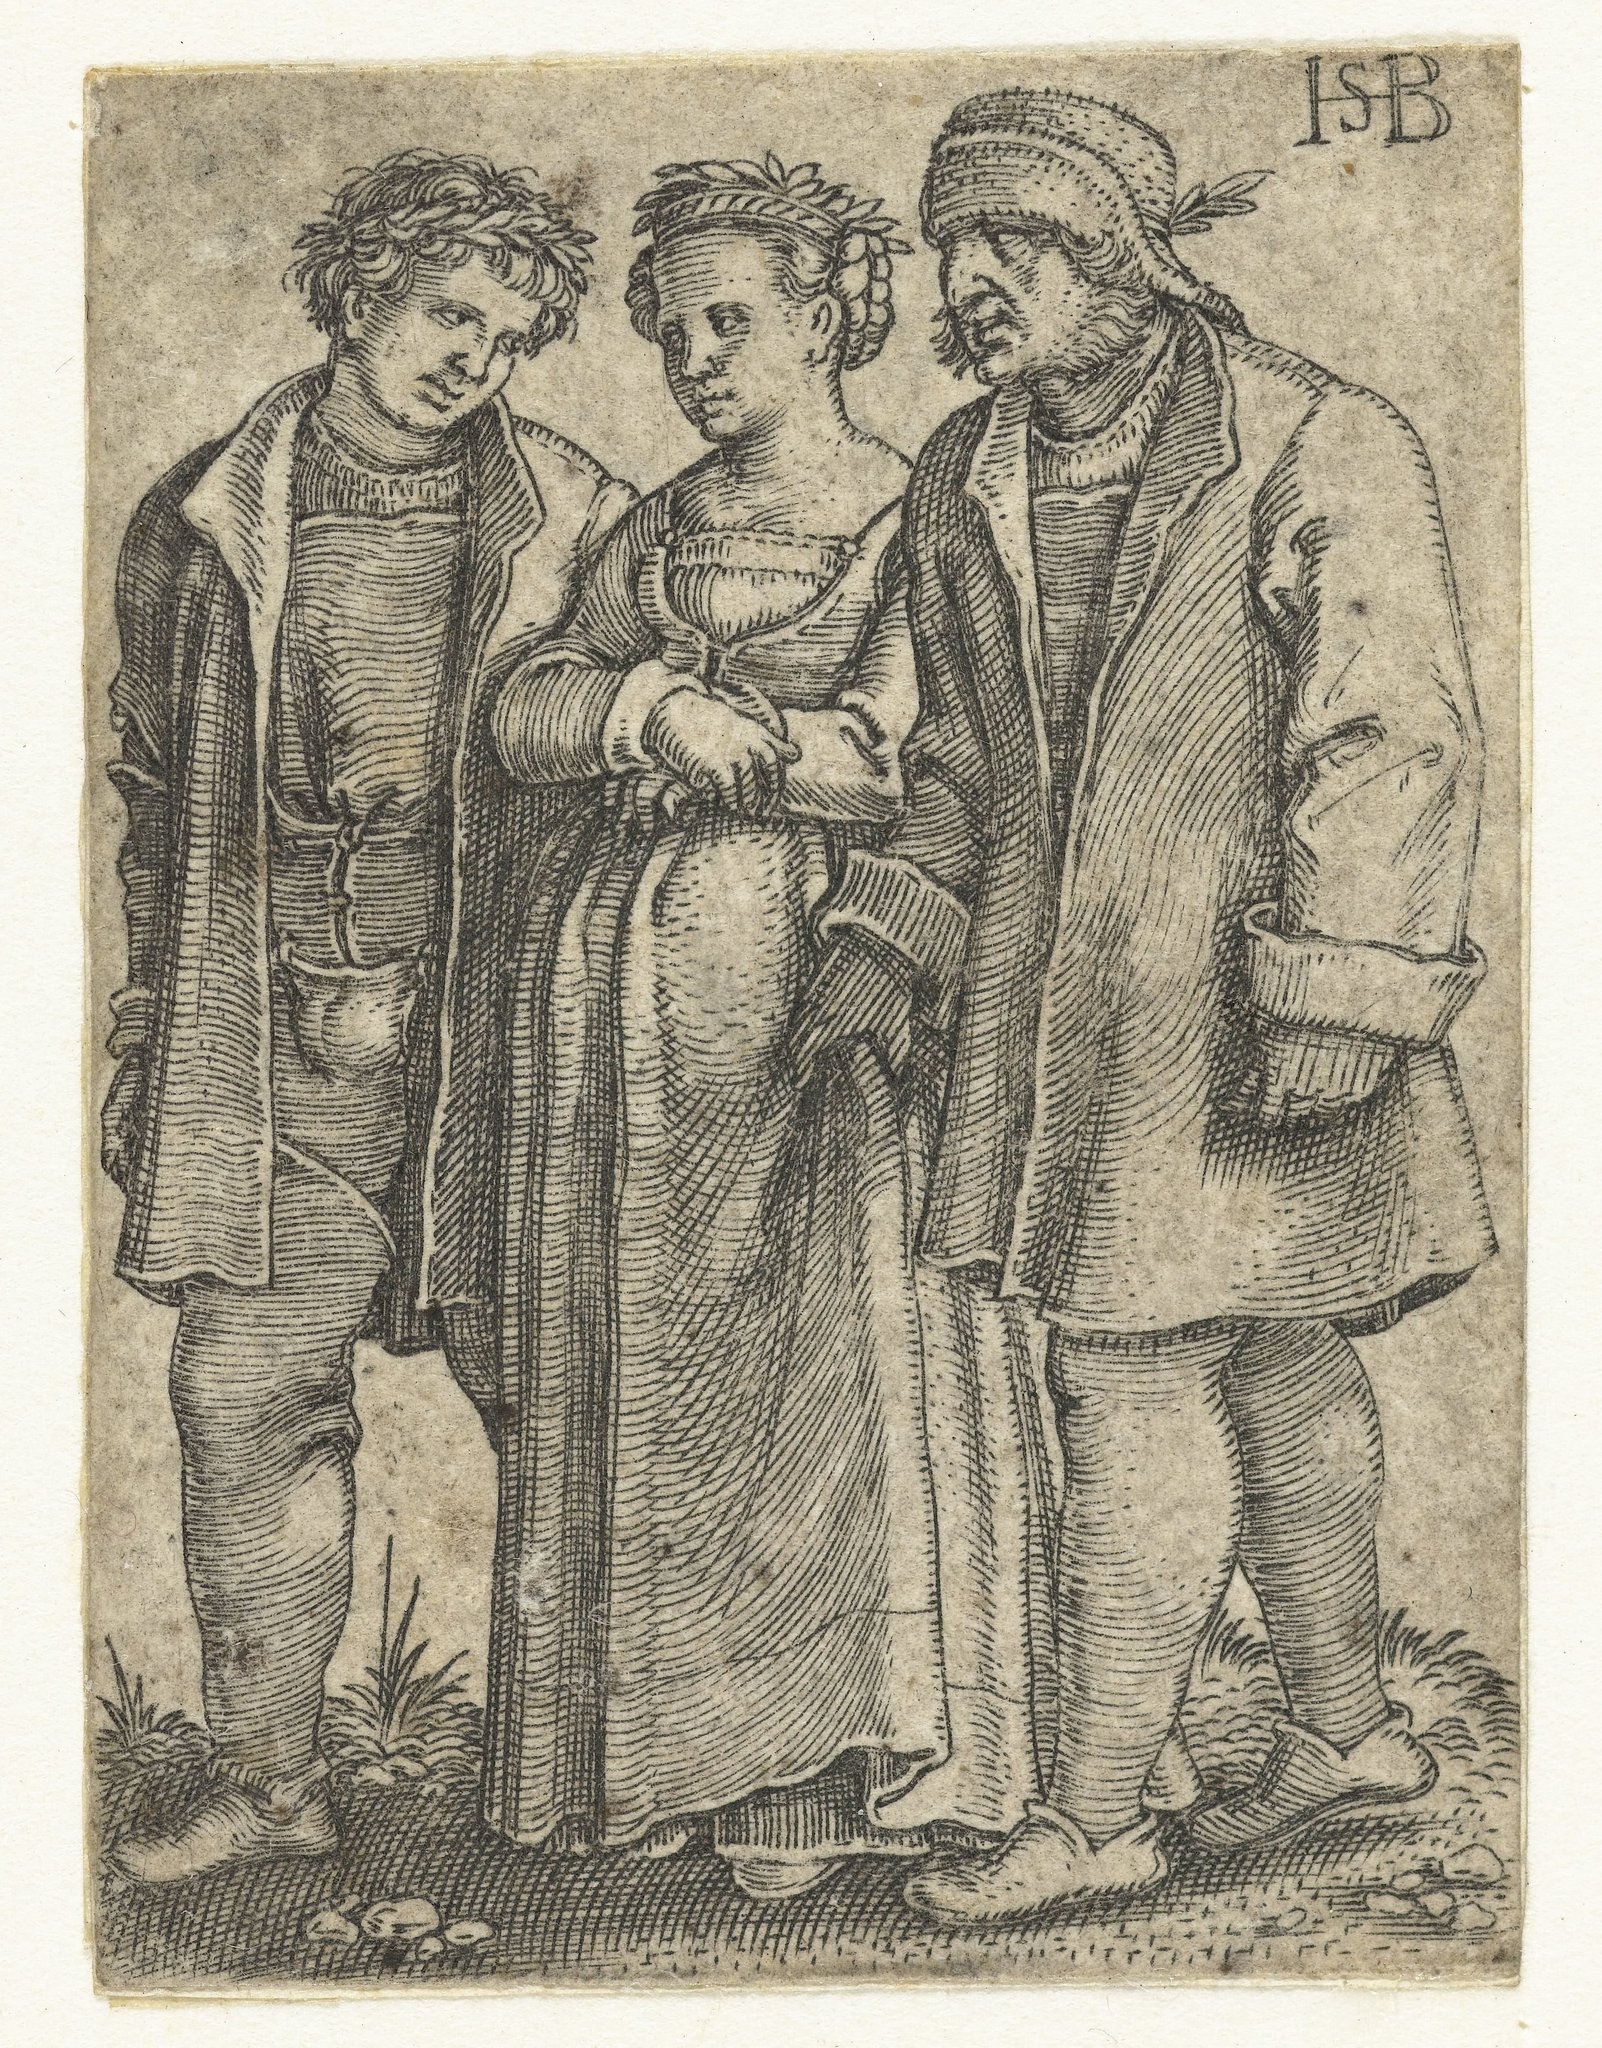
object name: print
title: Bruidspaar en vader van de bruid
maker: hans sebald beham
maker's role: designer, draughtsman, print maker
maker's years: 1500-1550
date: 1510-1550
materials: paper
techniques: engraving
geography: germany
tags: presenting the bride to the man, bride and groom in wedding-dress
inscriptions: collector's mark: Lugt 2228a, collector's mark: Lugt 2204, collector's mark: Lugt 2193, collector's mark: Lugt 1053